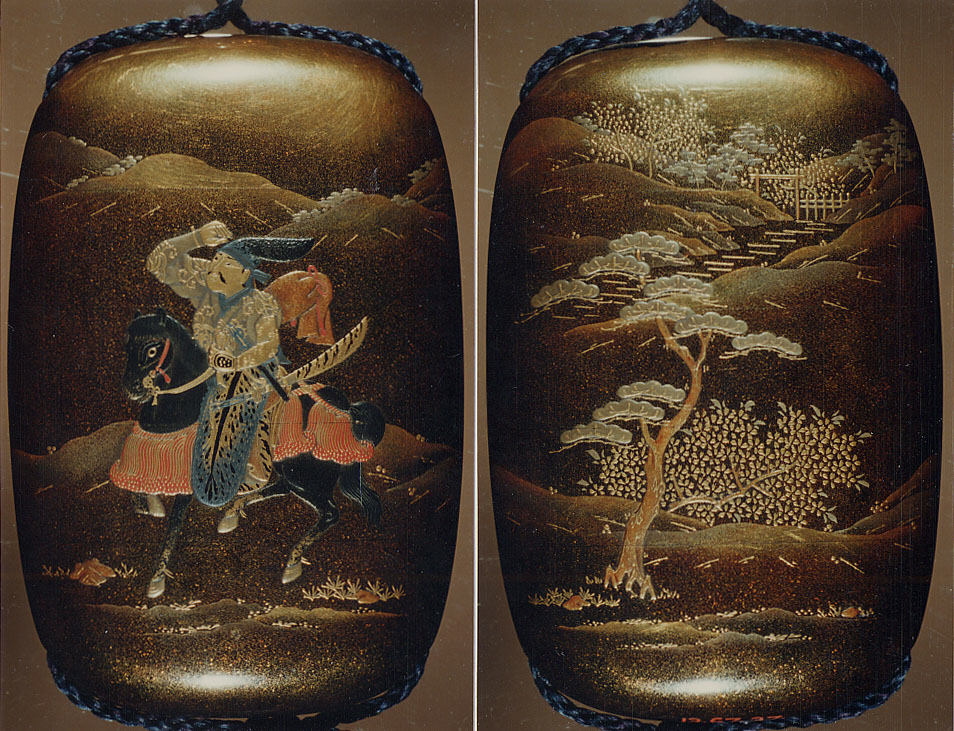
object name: inrō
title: Case (Inrō) with Design of Courtier on Horseback (obverse); Landscape with Trees (reverse)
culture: japanese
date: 1801-2000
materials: gold, lacquer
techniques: fundame, hiramakie, maki-e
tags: swords,men,horses,trees